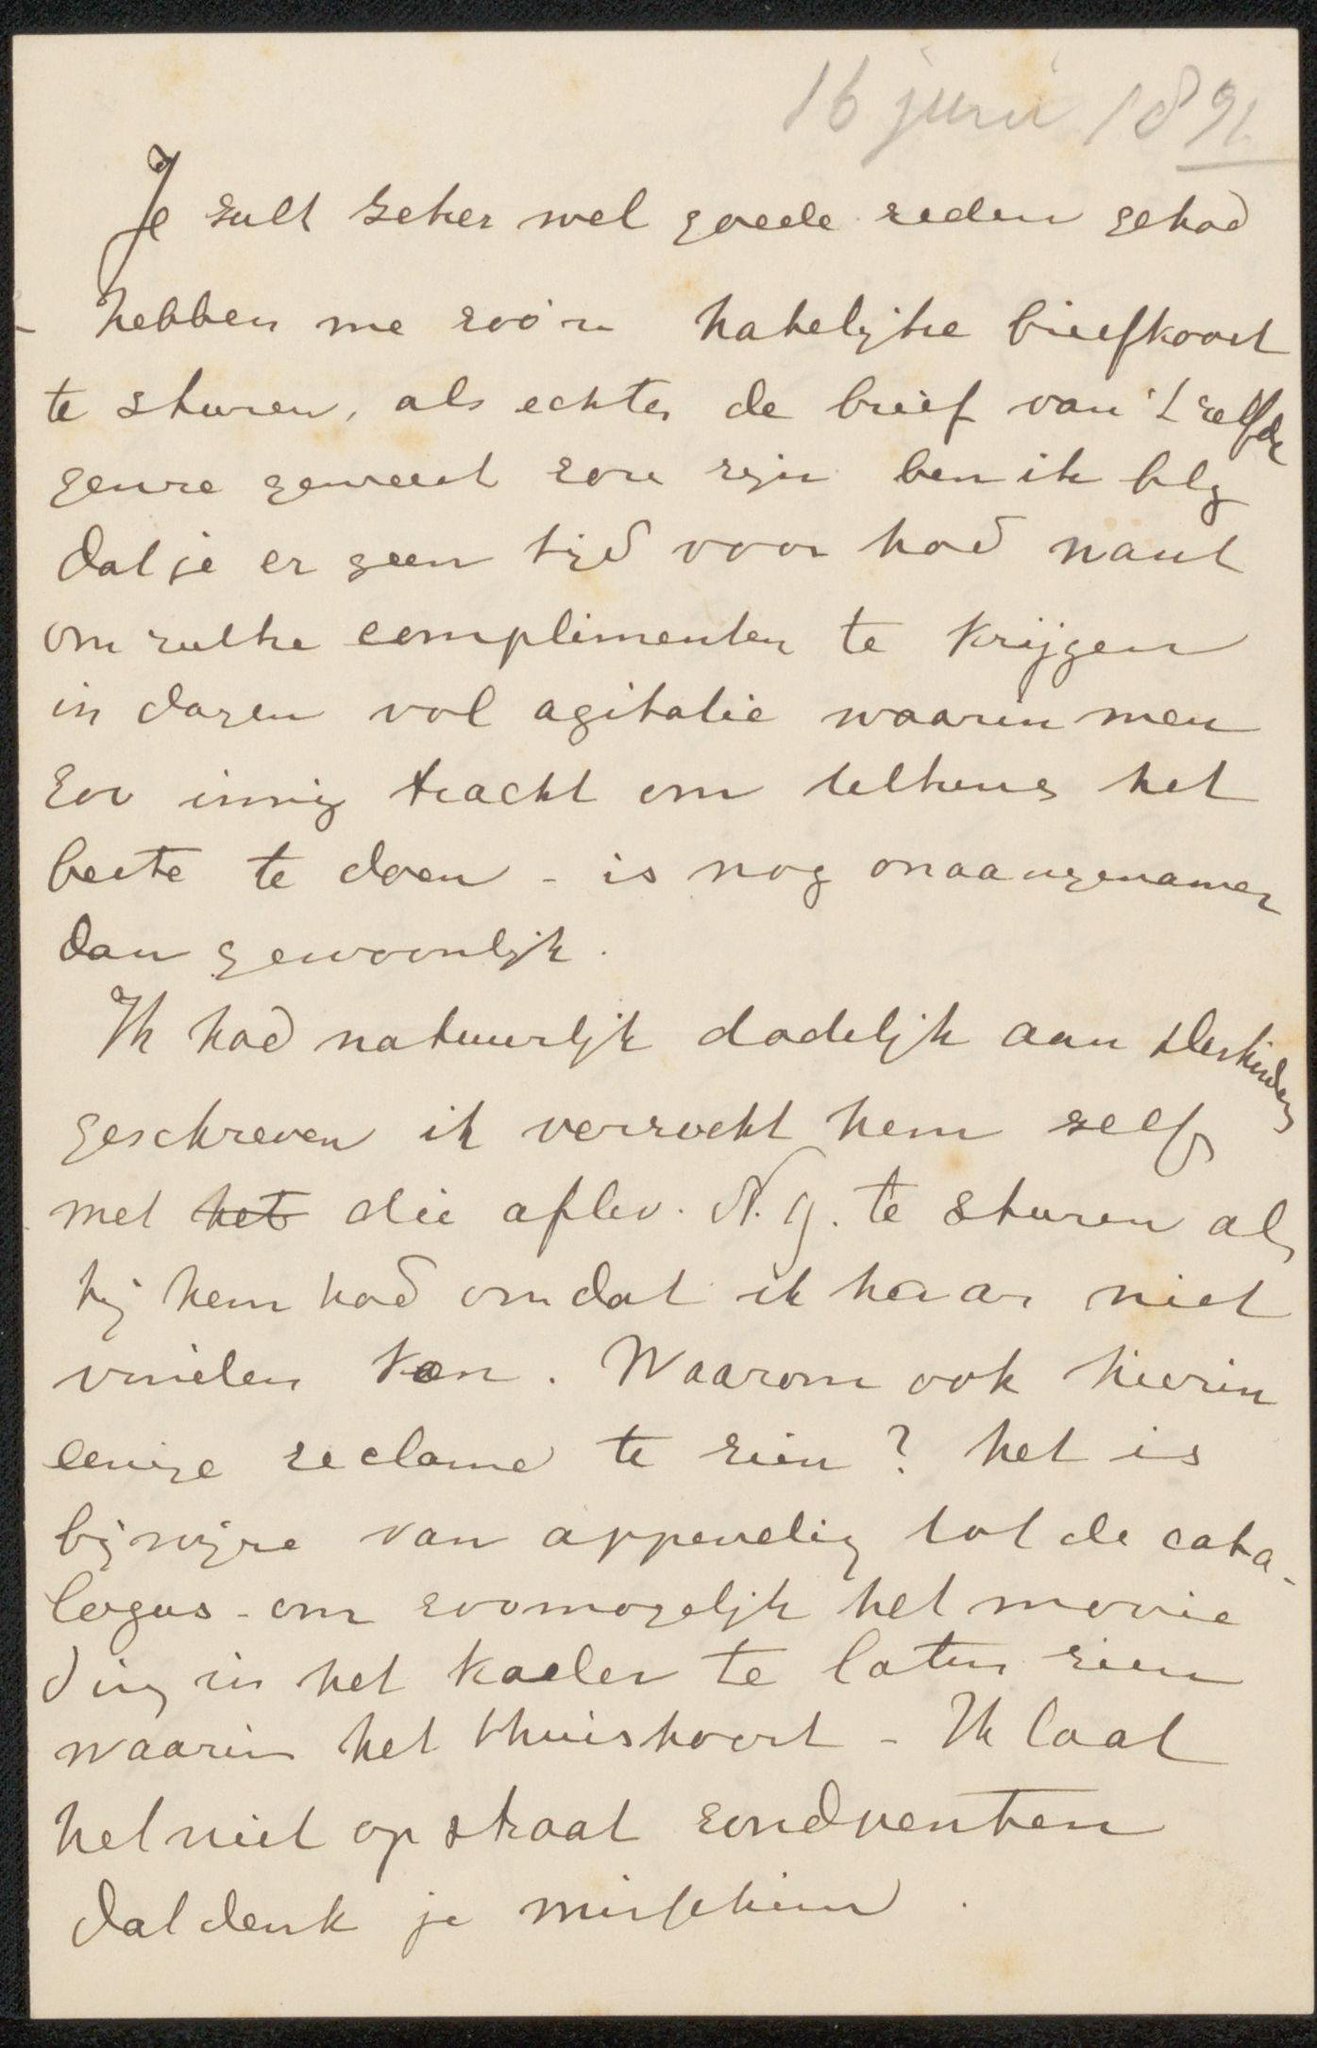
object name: letter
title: Brief aan Jan Veth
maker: etha fles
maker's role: print maker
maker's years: 1857-1948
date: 1874-1925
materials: ink, paper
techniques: pen, writing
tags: dordrecht, amsterdam, painter, print maker, draughtsman, designer, jan veth, antoon derkinderen, wally moes, applied arts, arts and crafts; industrial design, historical persons (portraits and scenes from the life), printed matter, brussels, utrecht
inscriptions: watermark, collector's mark: ‘RPK’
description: Brief gedateerd 16 juni 1891 in latere hand.